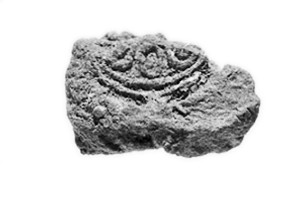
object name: sealing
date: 1981-1640 BCE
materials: mud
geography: egypt